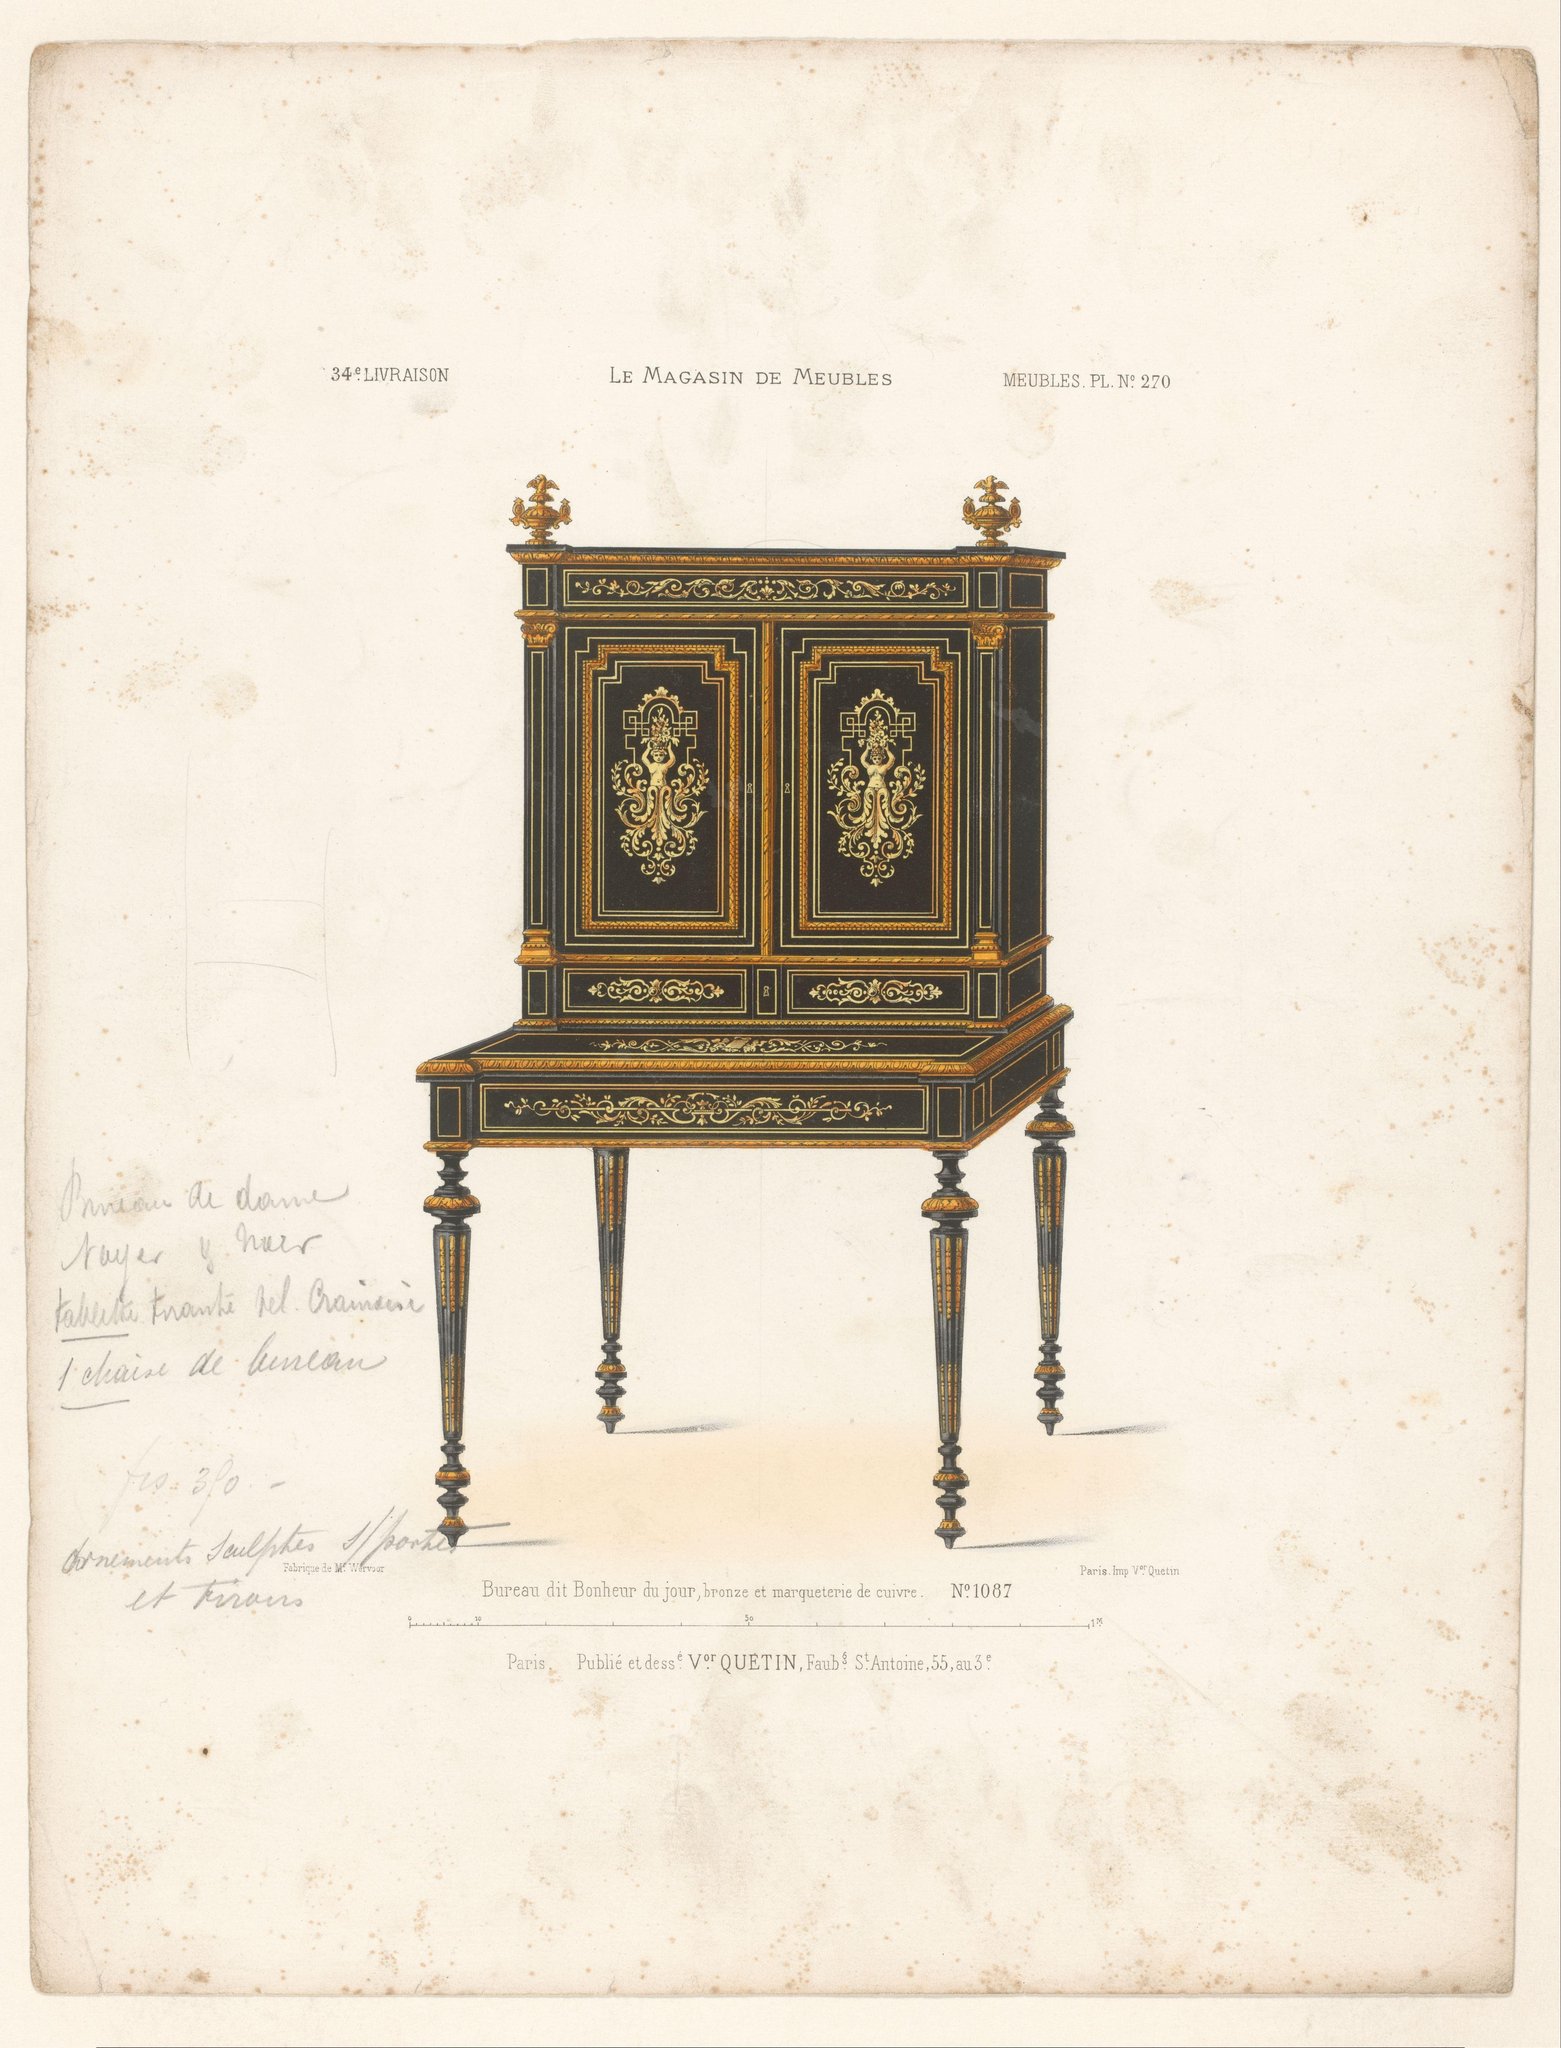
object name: print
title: Bureau dit Bonheur du jour, bronze et marqueterie de cuivre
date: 1832-1877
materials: paper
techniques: hand coloring, lithograph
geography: paris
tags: writing-table, writing-desk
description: Een bonheur du jour. Prent uit 34e Livraison.